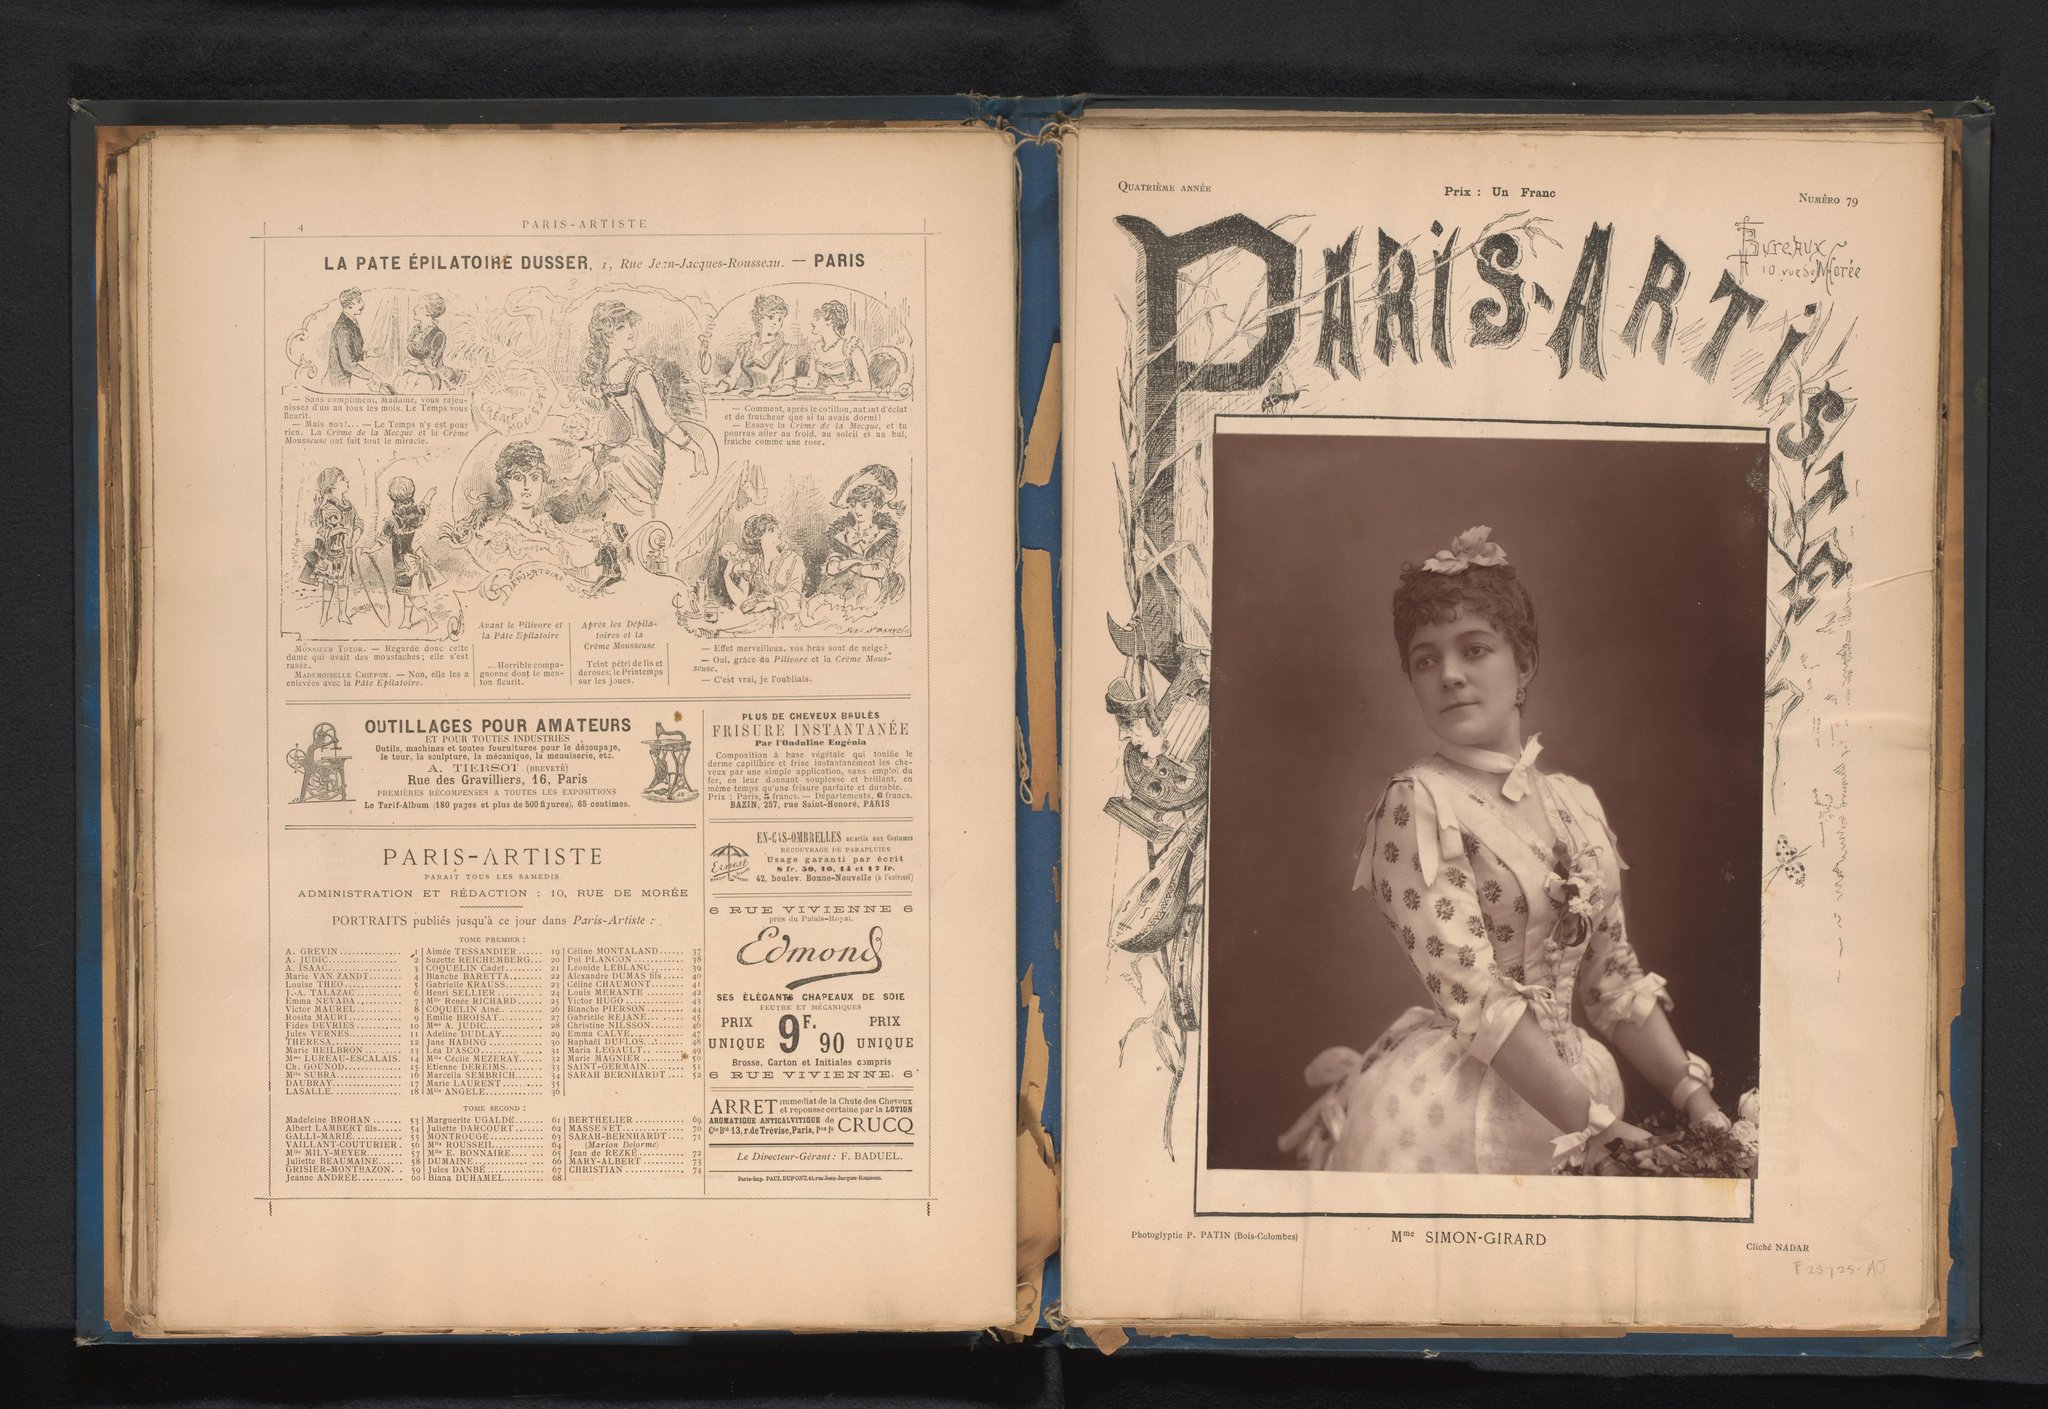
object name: photomechanical print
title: Portret van Juliette Simon-Girard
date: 1880-1886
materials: paper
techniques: woodburytype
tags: historical persons - bb - woman, opera-singer (female)